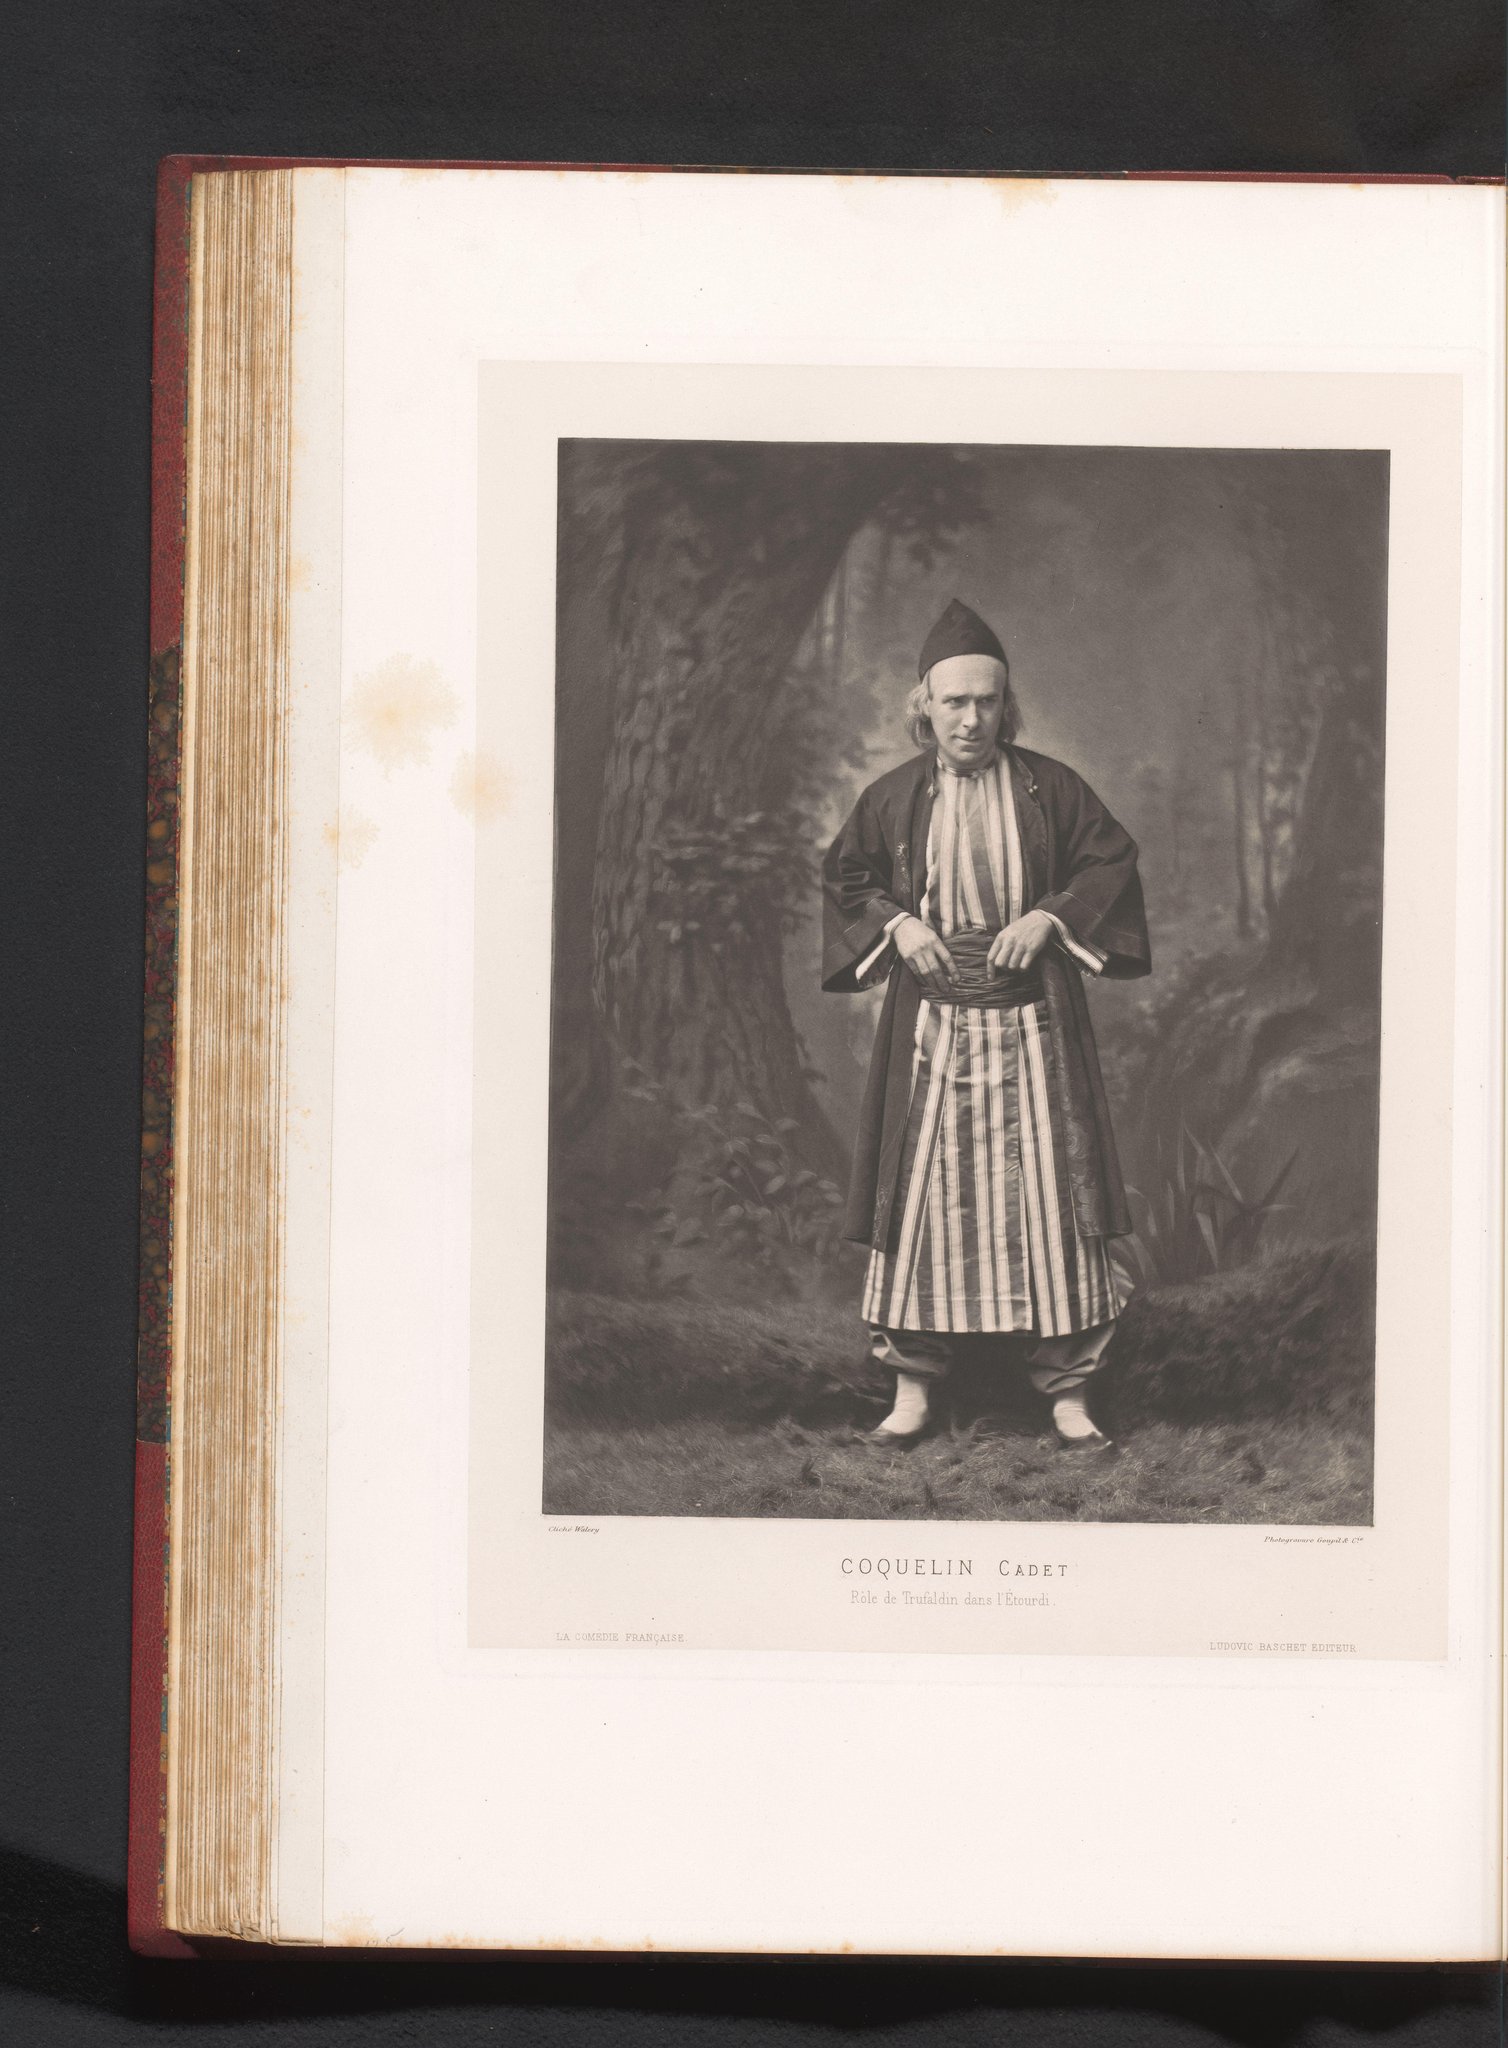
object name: photomechanical print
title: Coquelin Cadet. Rôle de Trufaldin dans l'Étourdi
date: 1875-1880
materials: paper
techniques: photoaquatint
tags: historical persons, portrait of actor, actress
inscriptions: number: ‘[125]’, inscription: ‘LA COMÉDIE FRANÇAISE’